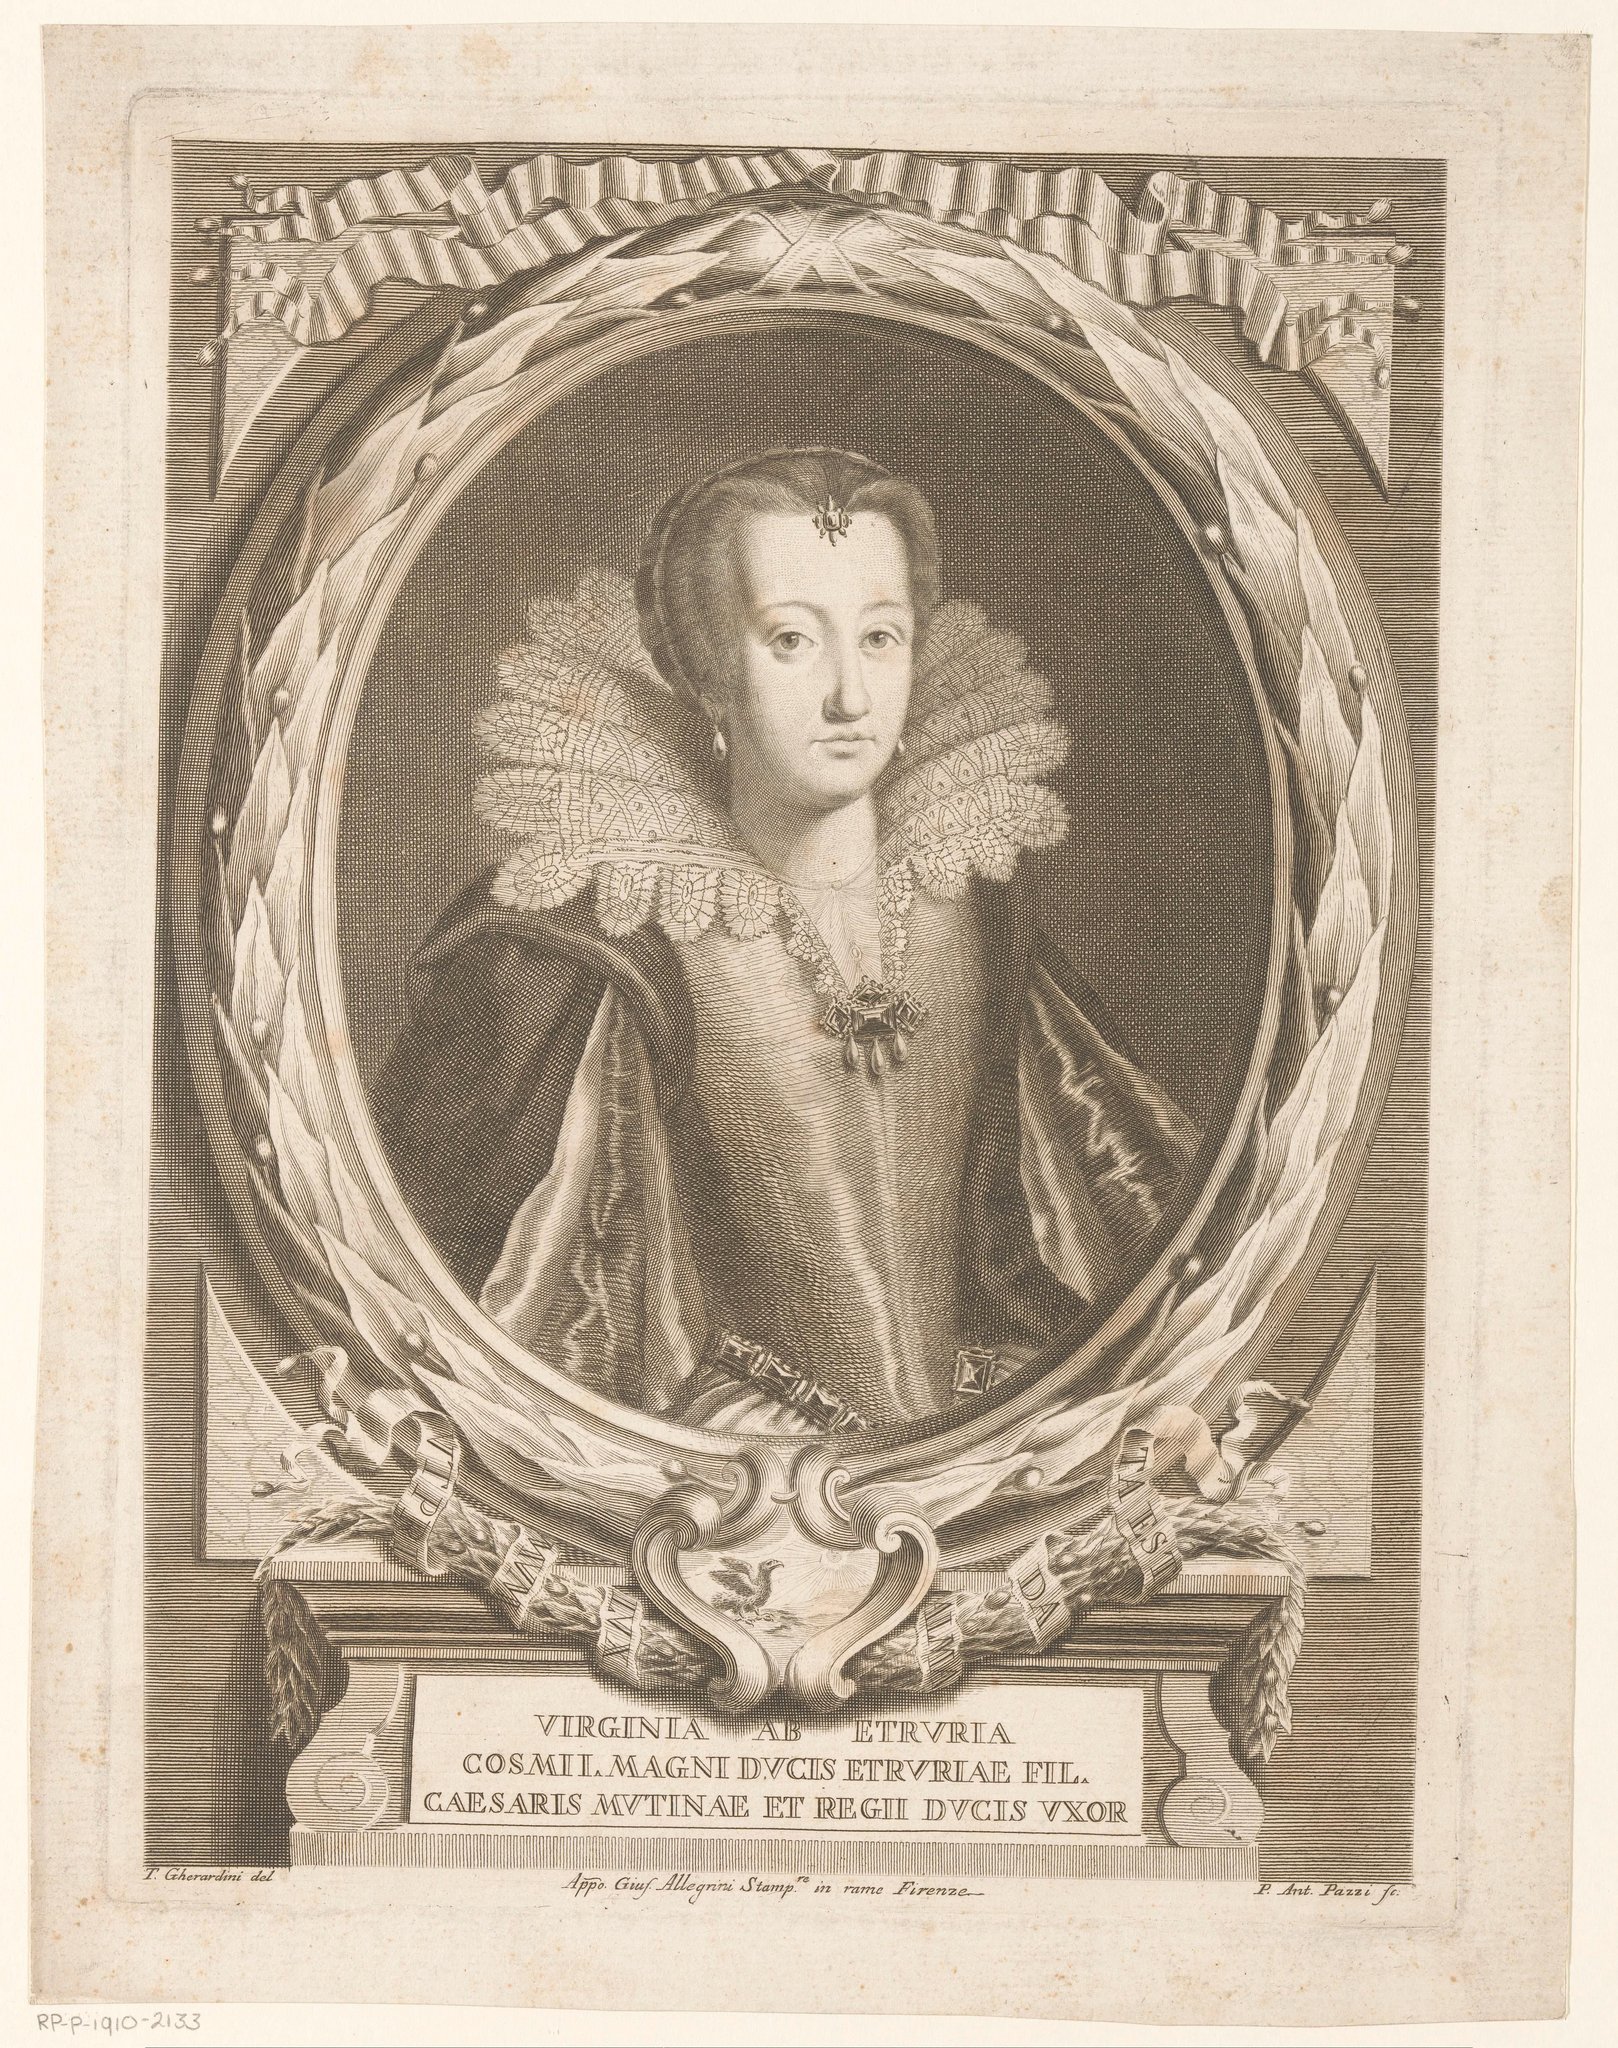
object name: print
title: Portret van Virginia de' Medici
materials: paper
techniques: engraving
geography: italy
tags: historical persons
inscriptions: collector's mark: Lugt 2228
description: Deze prent maakt deel uit van een serie van onbekende omvang met portretten van de familie De' Medici. De ornamentlijst is vergelijkbaar met de ornamentlijsten door Adriaen Haelwegh in een serie van 31 prenten met portretten van de familie De' Medici.